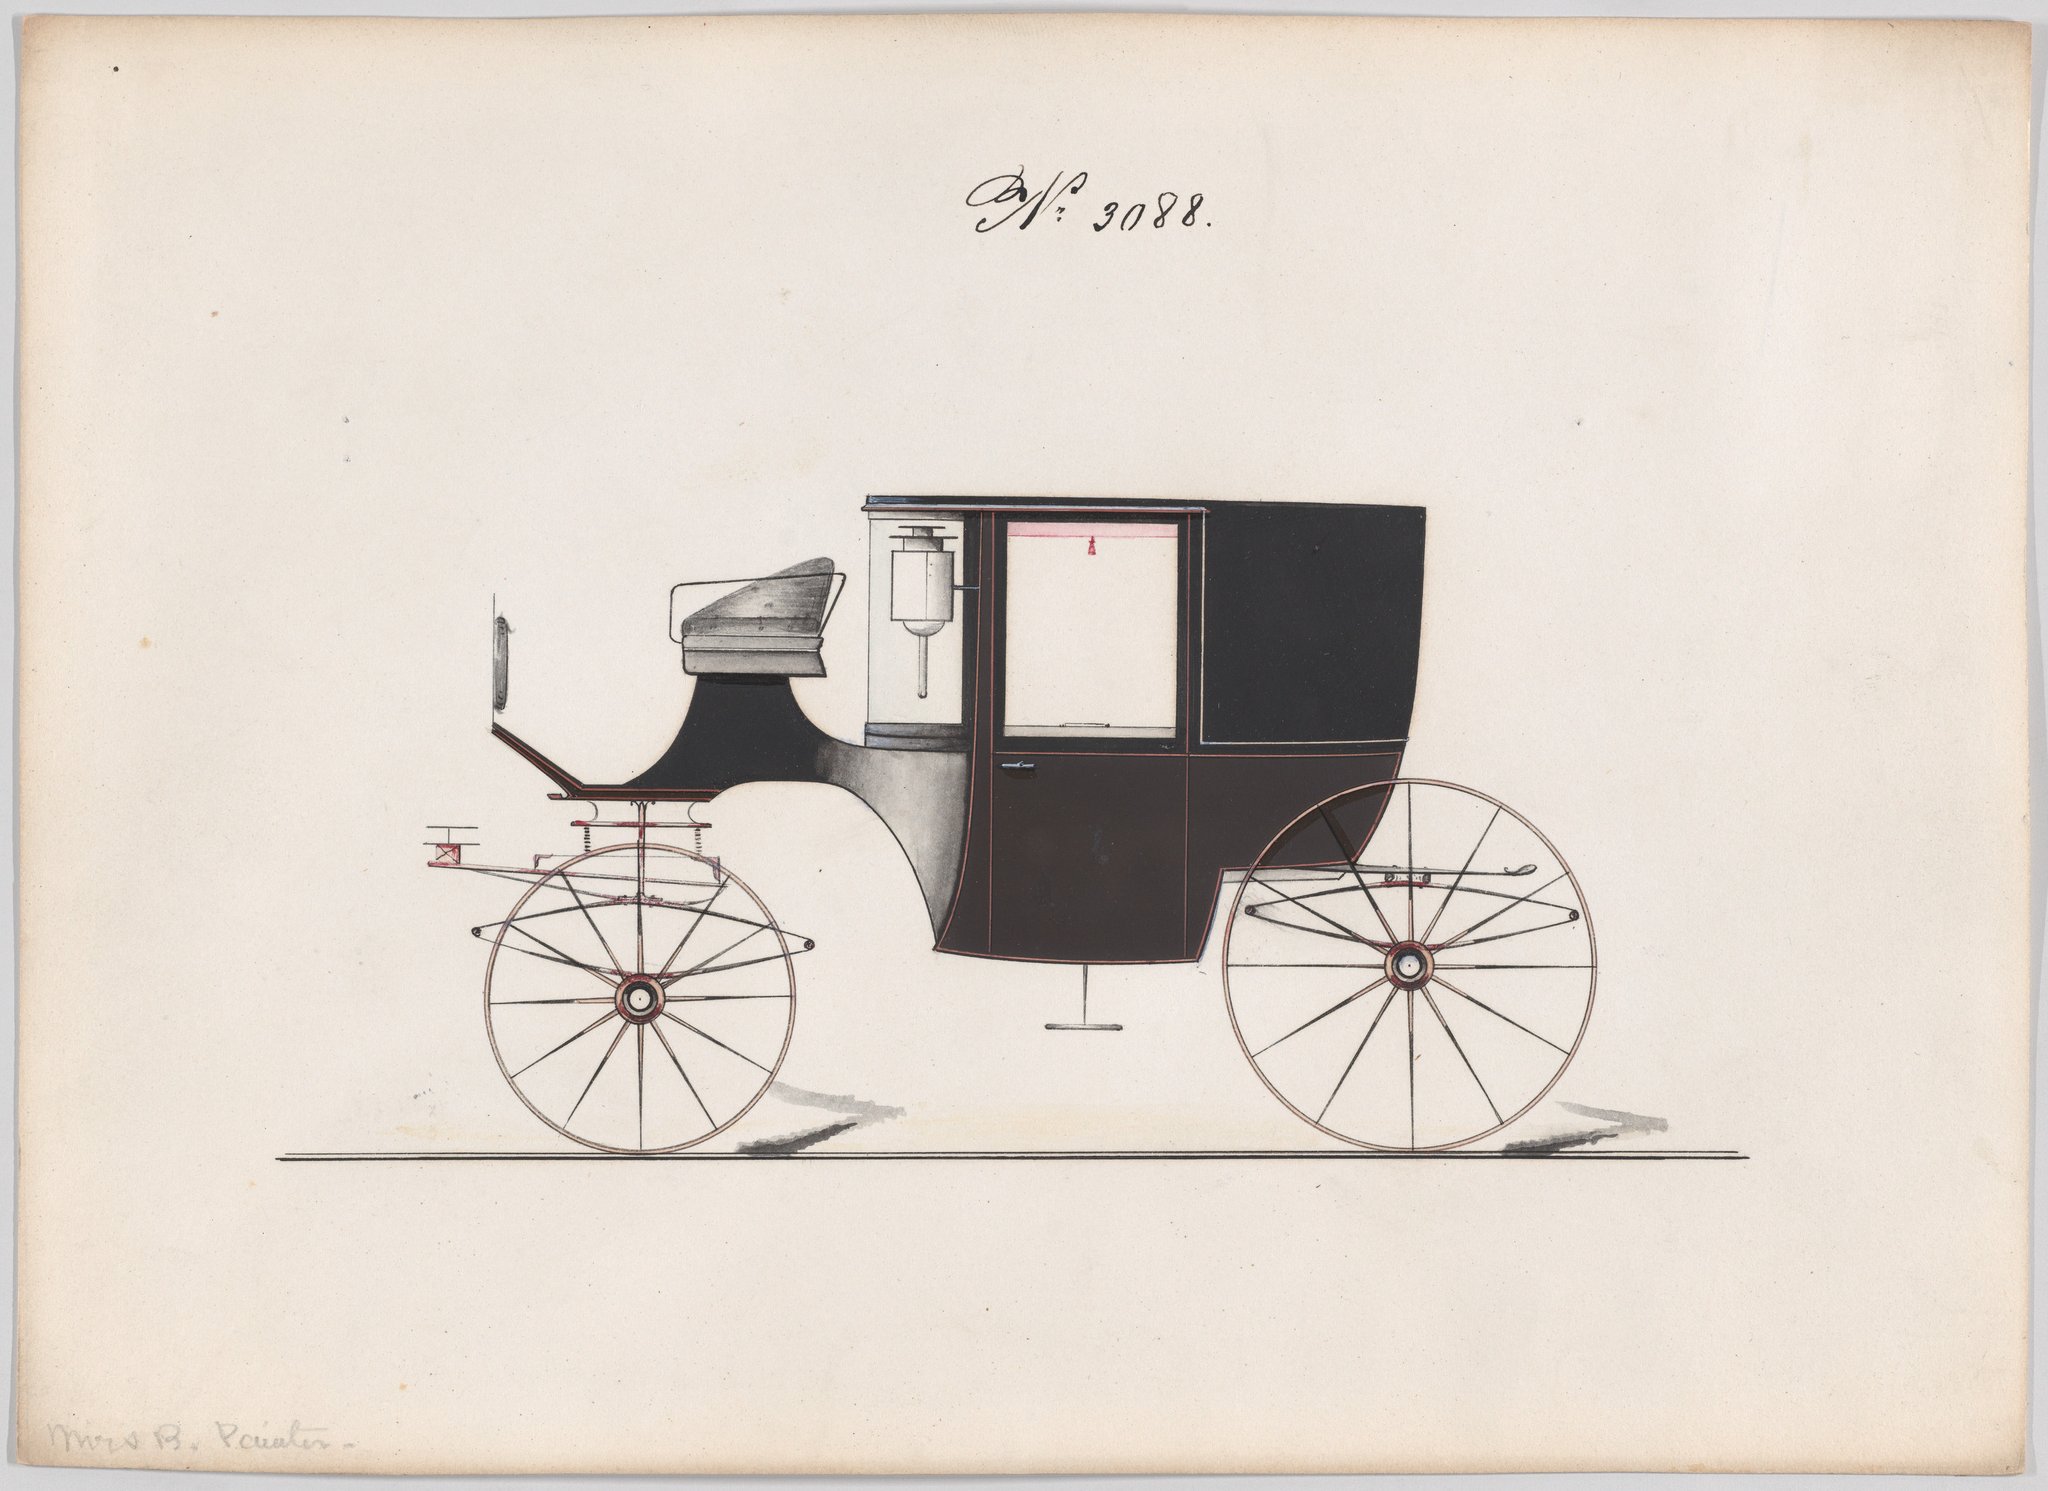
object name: drawing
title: Design for Coupé, no. 3088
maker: brewster & co.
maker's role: manufacturer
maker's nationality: american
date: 1875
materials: gouache, gum arabic, ink, watercolor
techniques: pen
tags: carriages